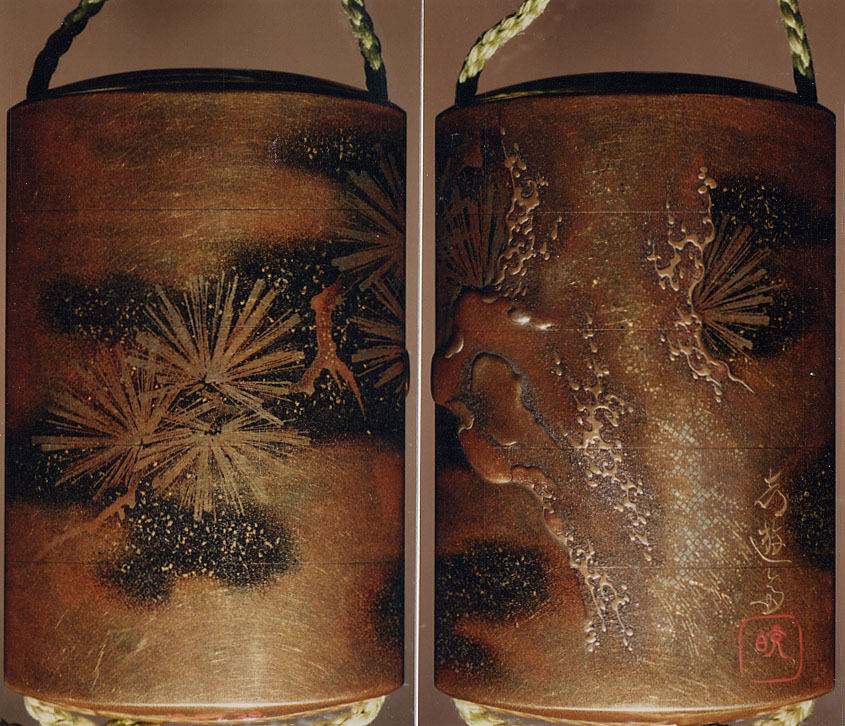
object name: inrō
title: Case (Inrō) with Design of Pine Trees and Snow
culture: japanese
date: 1801-1900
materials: gold, lacquer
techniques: fundame, hiramakie, maki-e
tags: trees,snow